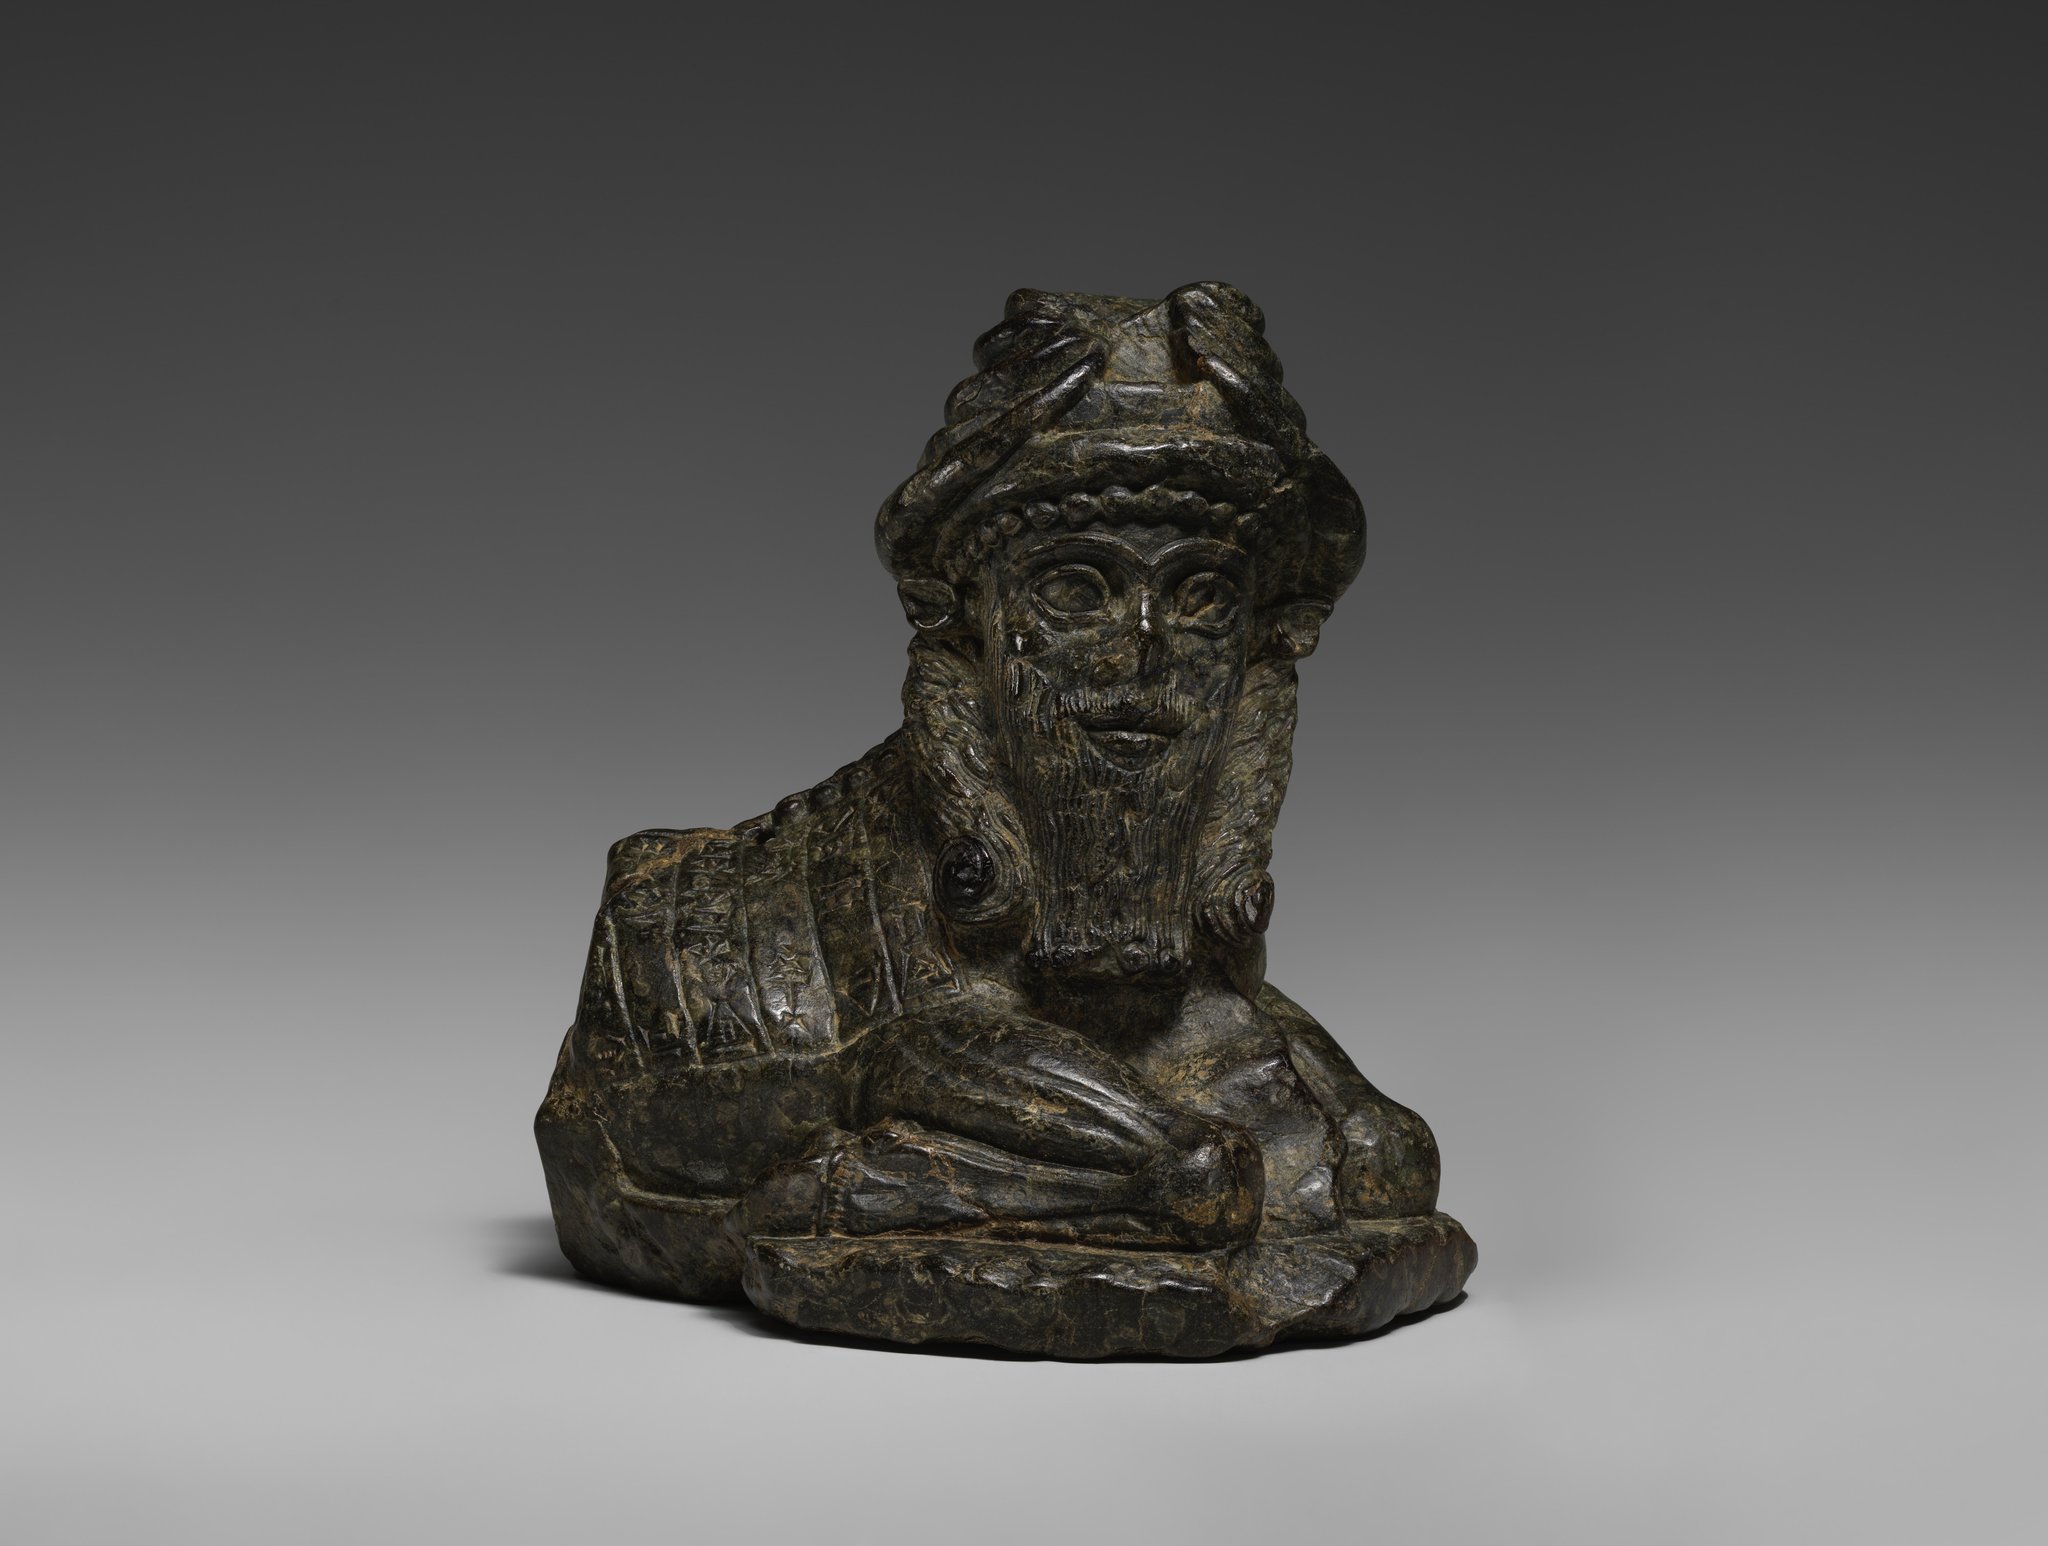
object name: sculpture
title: Human-headed bison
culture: neo-sumerian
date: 2080 BCE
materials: stone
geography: mesopotamia